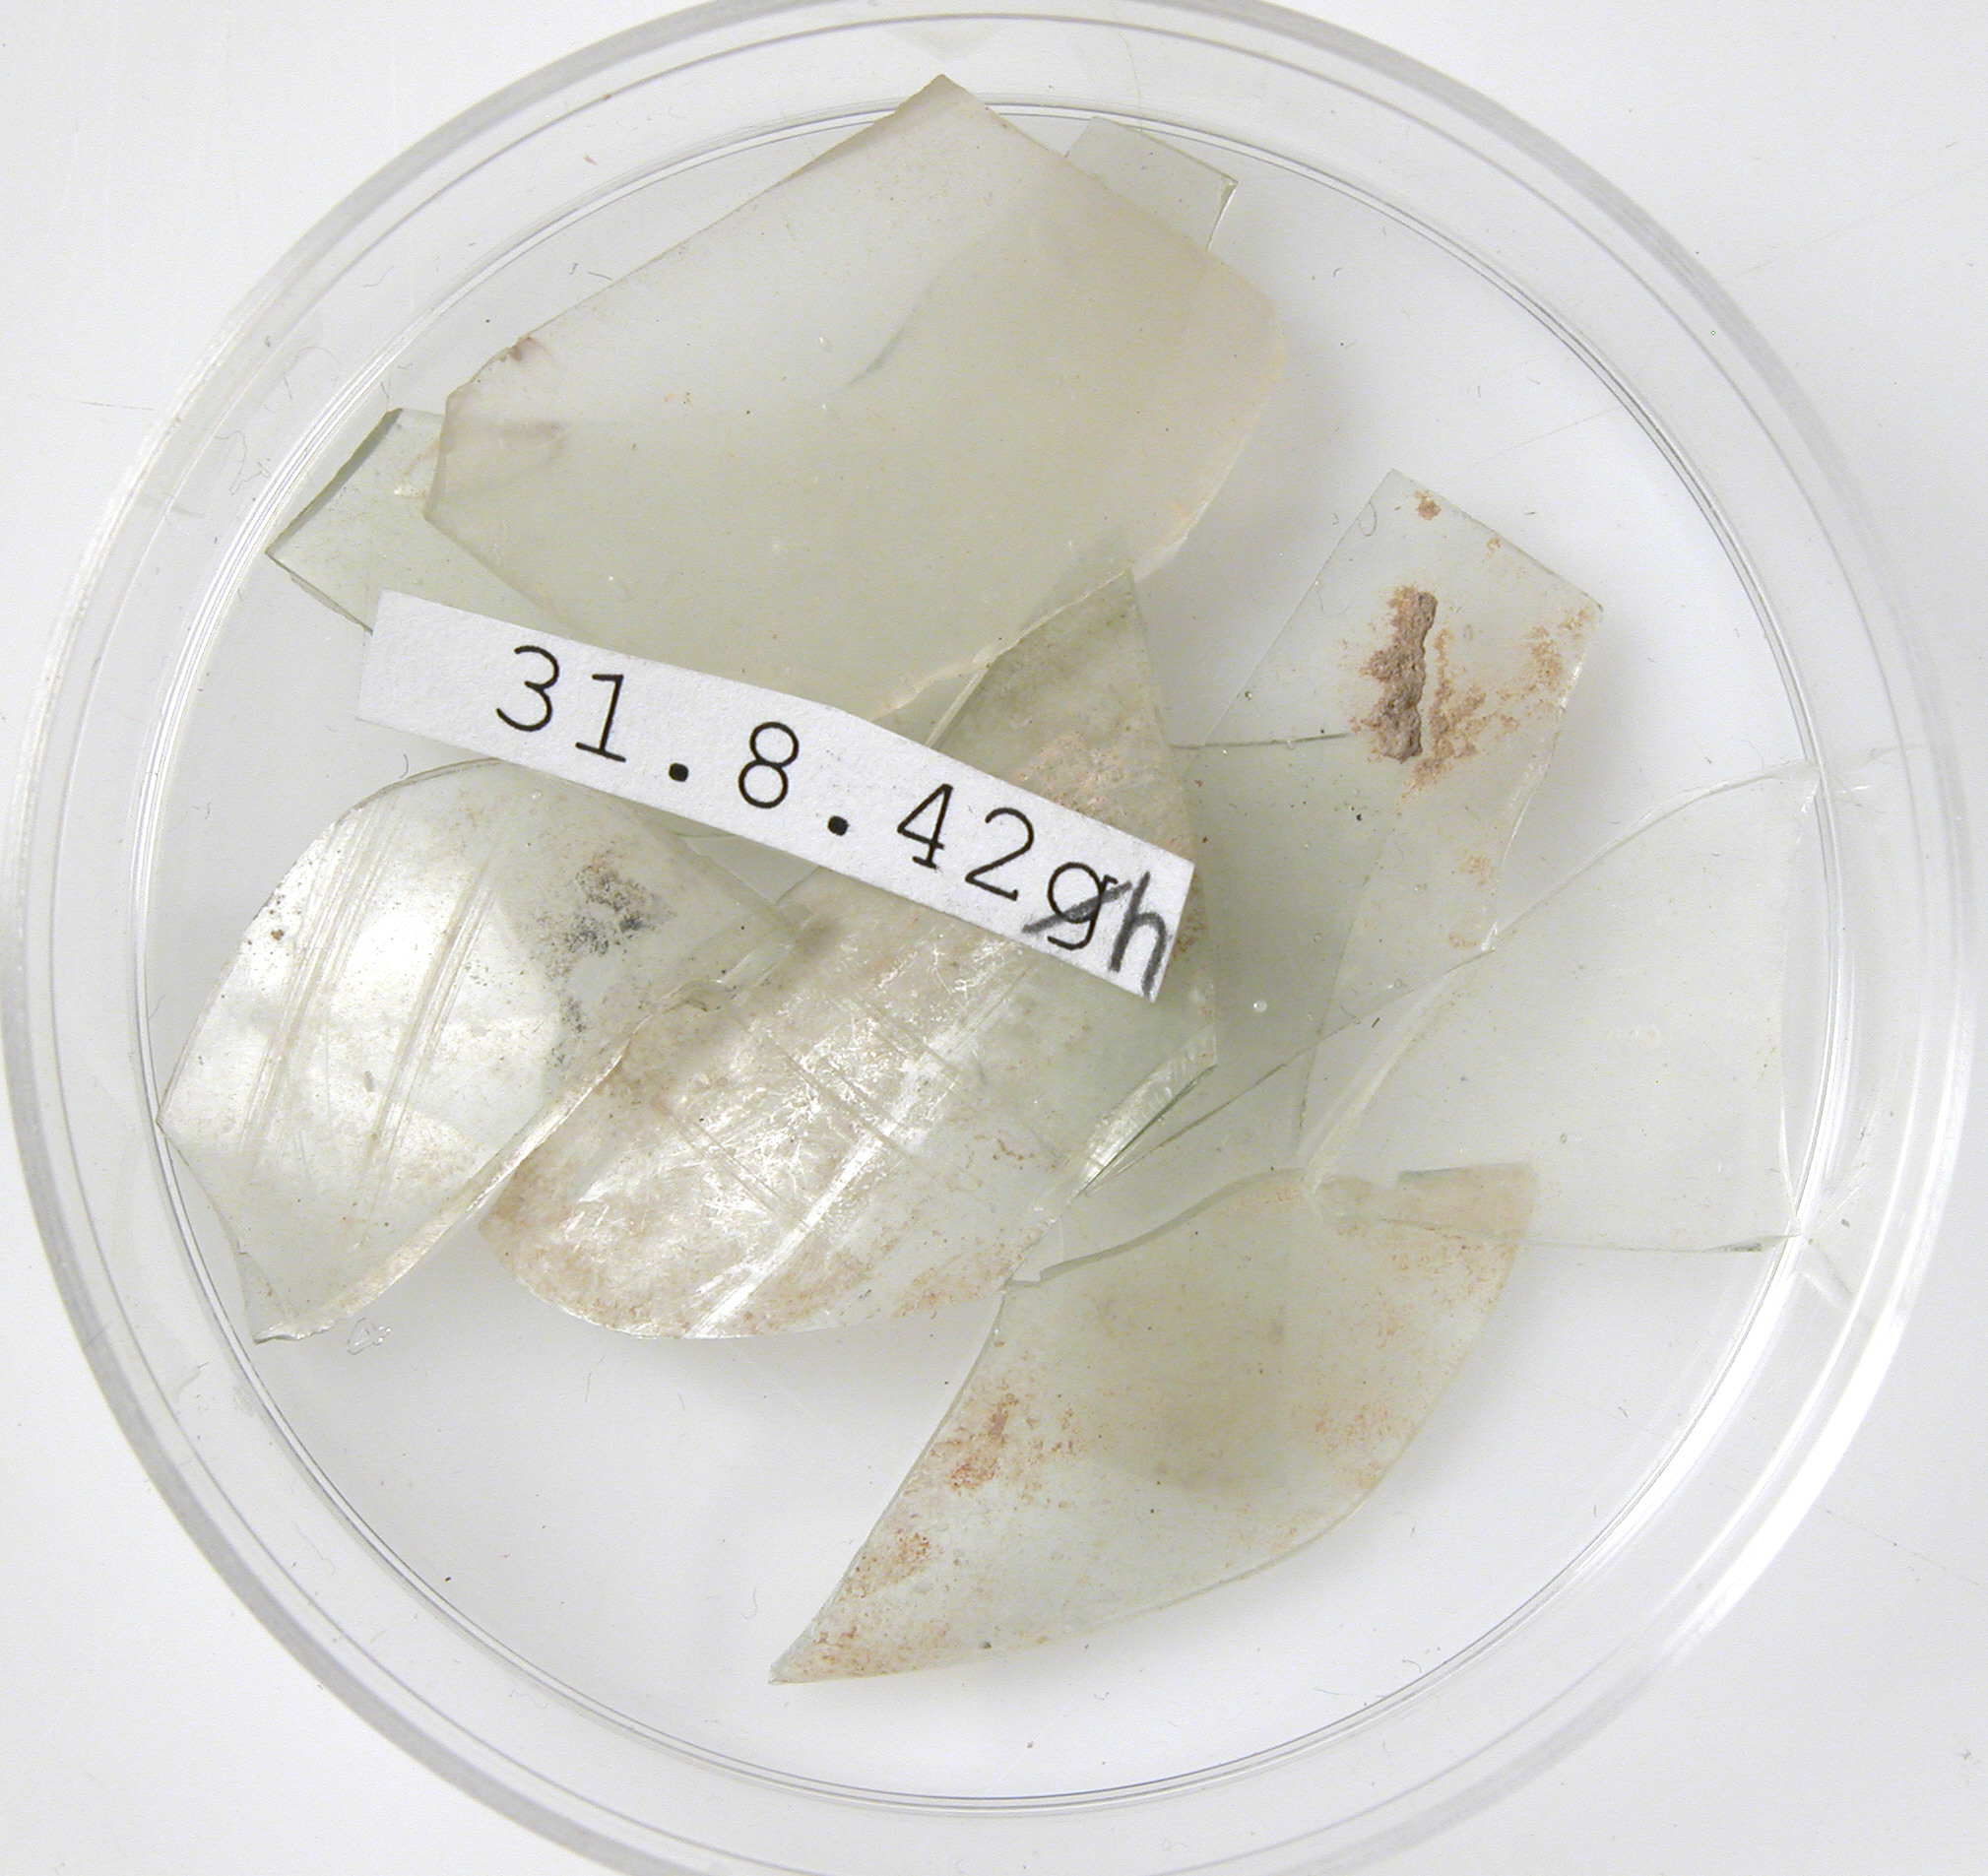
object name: fragment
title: Glass Fragments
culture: coptic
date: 301-400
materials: glass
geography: egypt